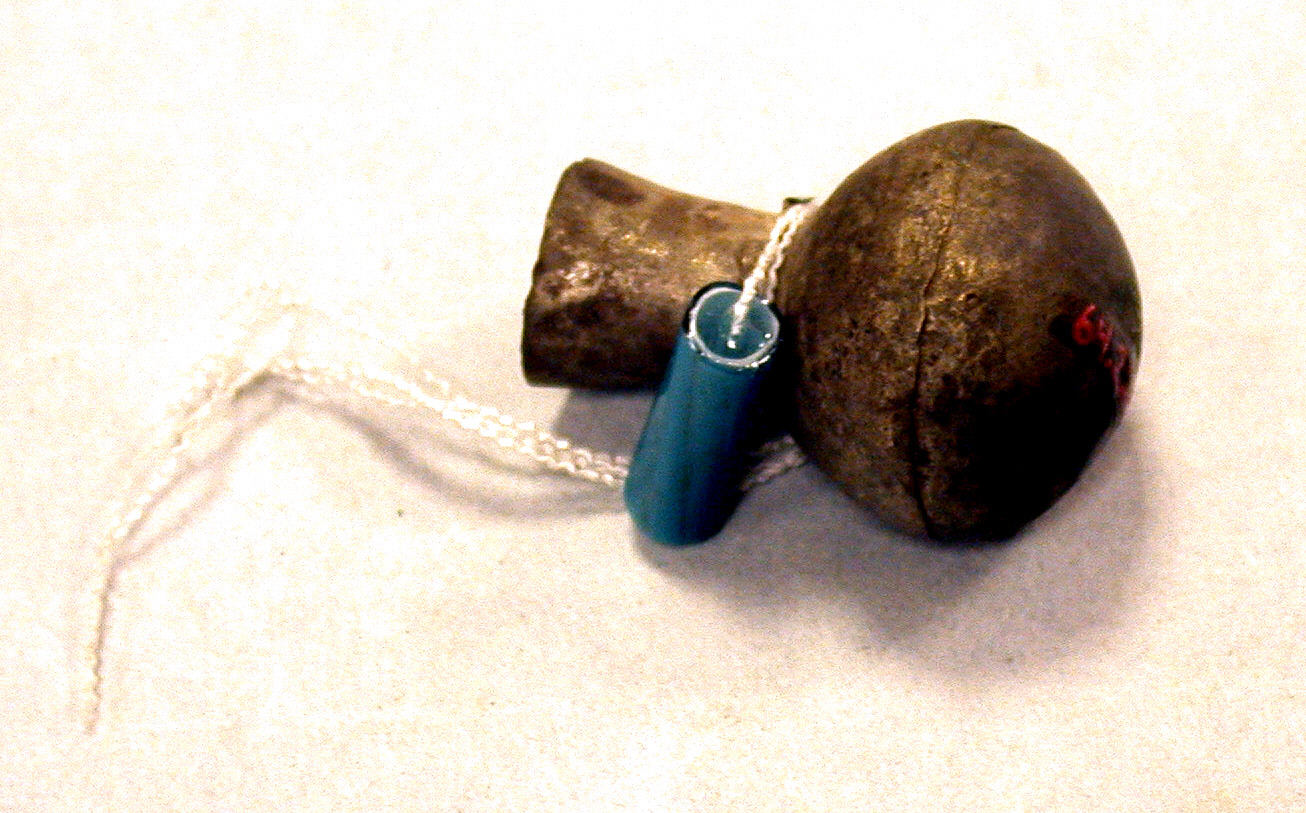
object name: bottle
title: Miniature Hammered Silver Bottle with Blue Bead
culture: peruvian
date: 701-1600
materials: gilt, silver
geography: peru